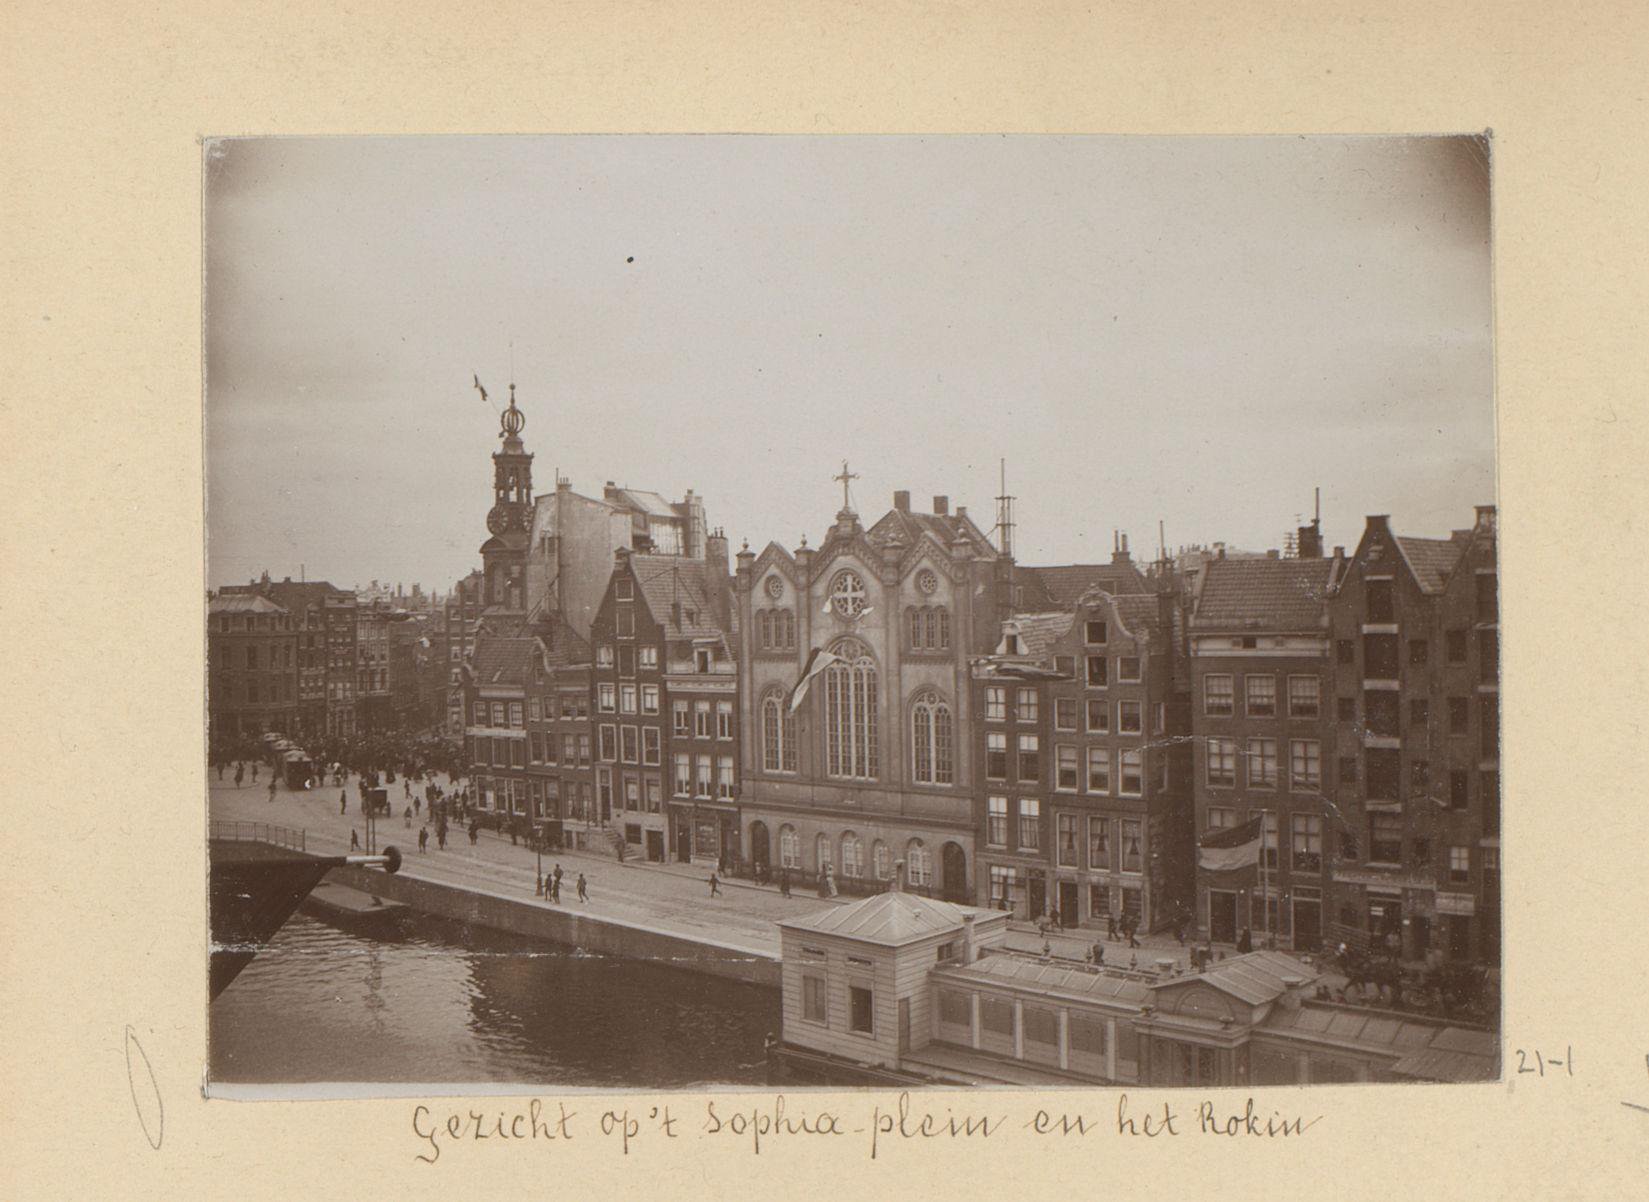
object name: album leaf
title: Gezicht op 't Sophia plein en het Rokin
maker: hendrik herman van den berg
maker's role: amateurfotograaf, jurist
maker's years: 1875-1944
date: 1890-1894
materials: paper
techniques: collodion silver print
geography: amsterdam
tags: city-view in general; 'veduta', canals, waters (in city)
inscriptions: inscription: ‘Amsterdam +/- 1890’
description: Foto 1 op albumblad 21 uit album "Amsterdam 1890-1894".